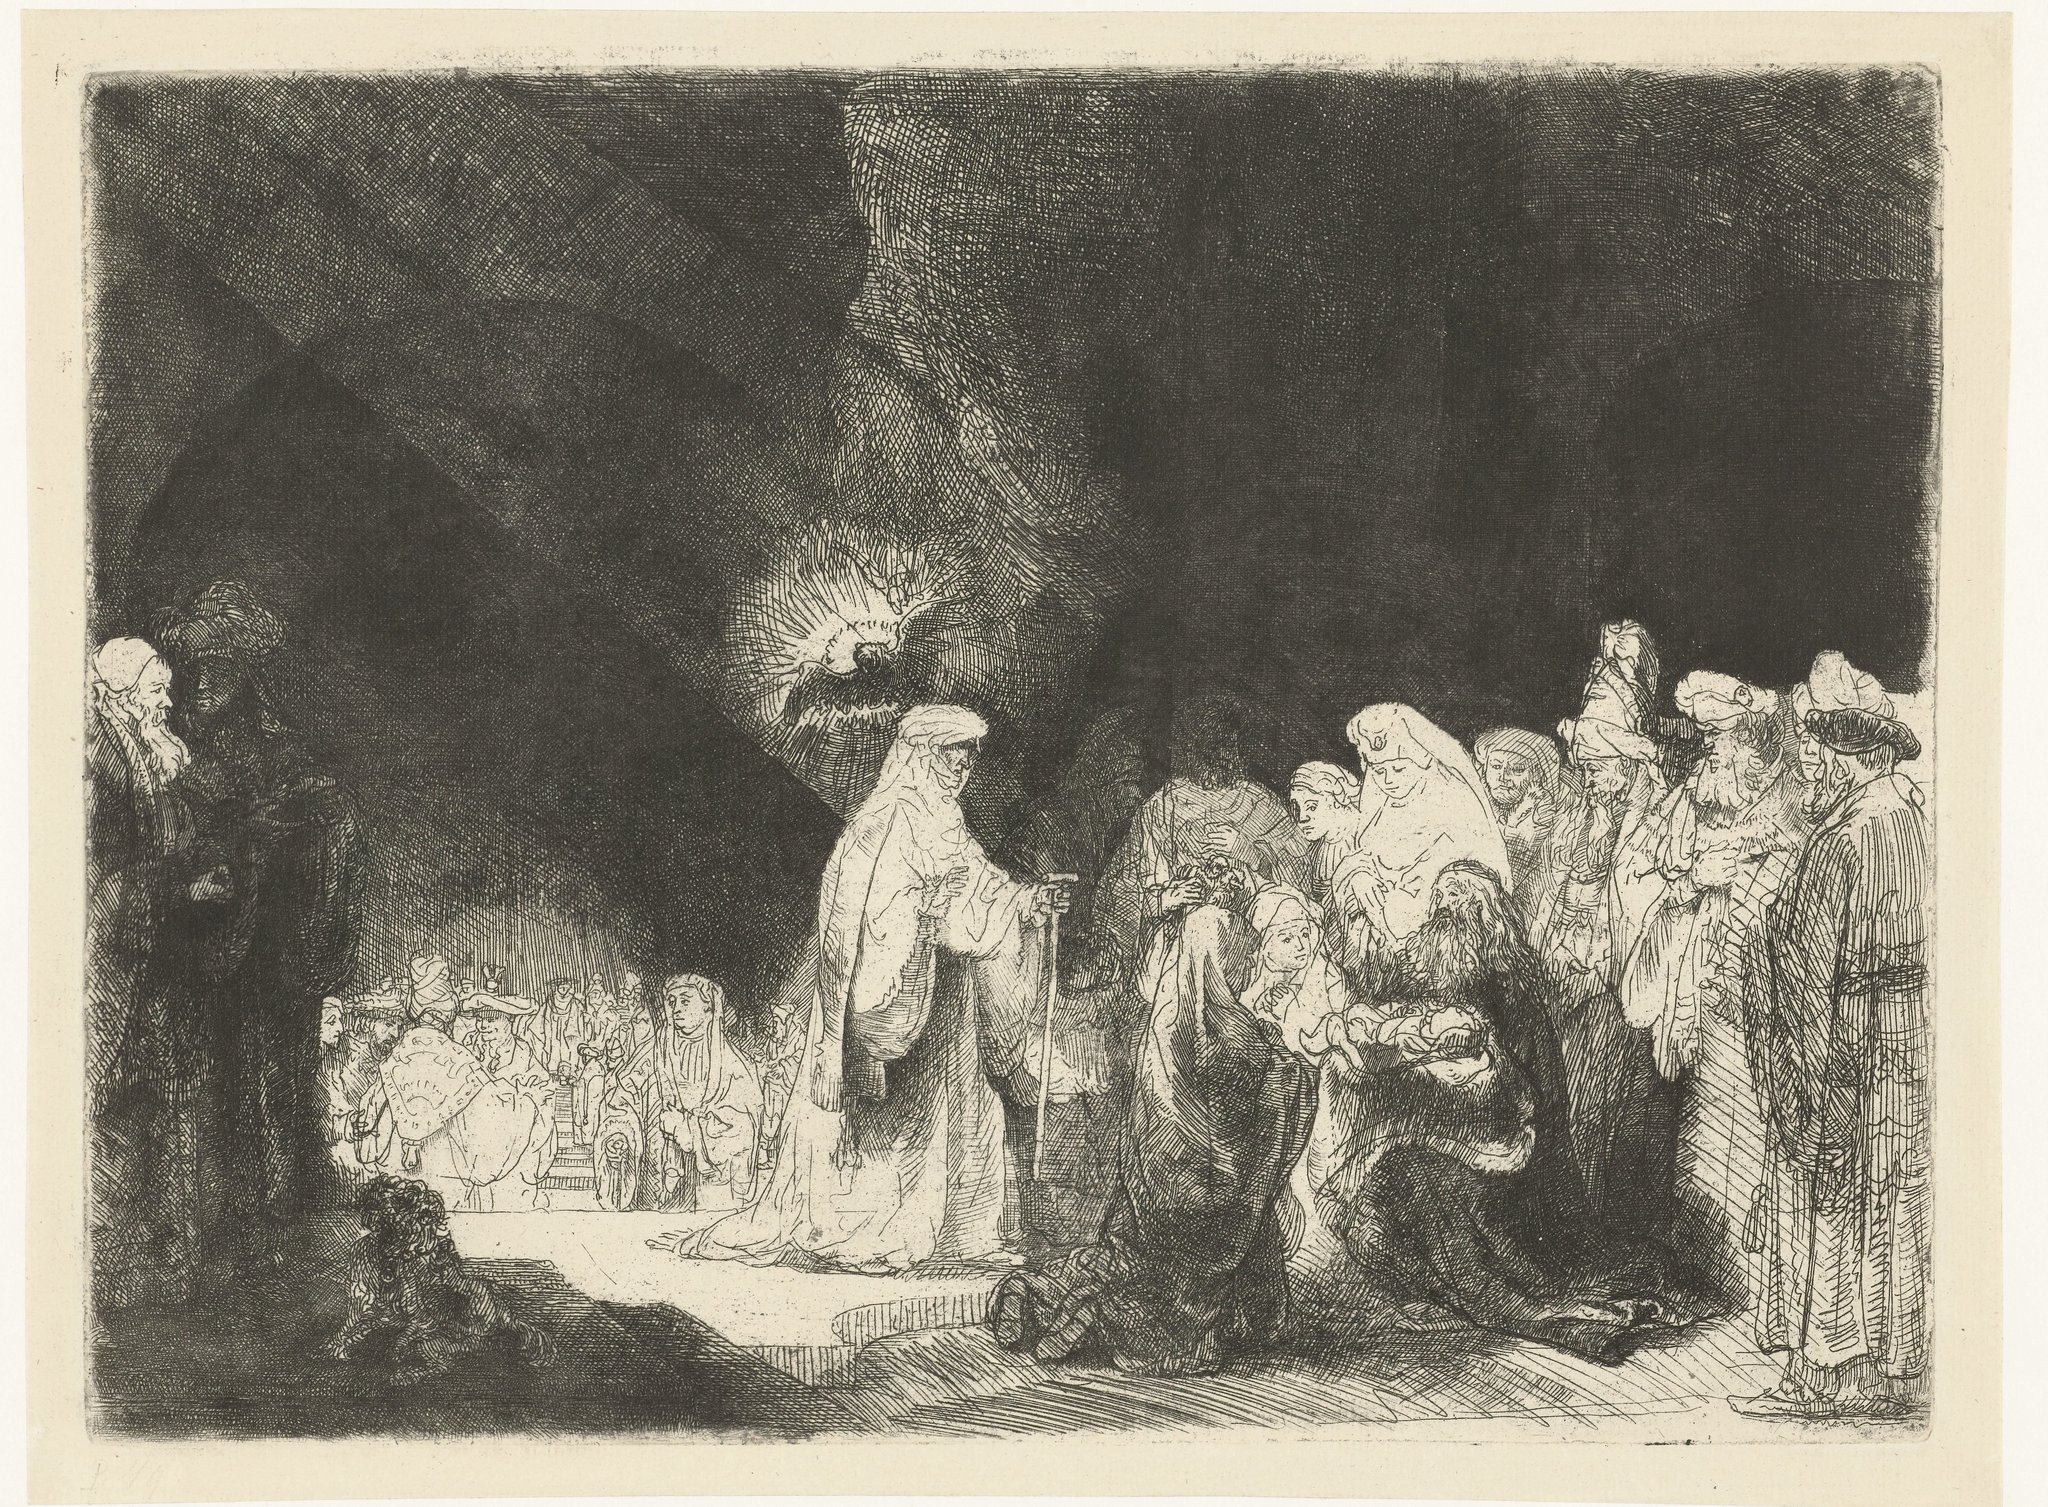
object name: print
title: The presentation in the temple: oblong print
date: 1850-1906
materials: paper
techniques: drypoint, etching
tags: simeon, holding the christ-child, sings his canticle: 'nunc dimittis'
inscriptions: inscription: ‘Coppier’